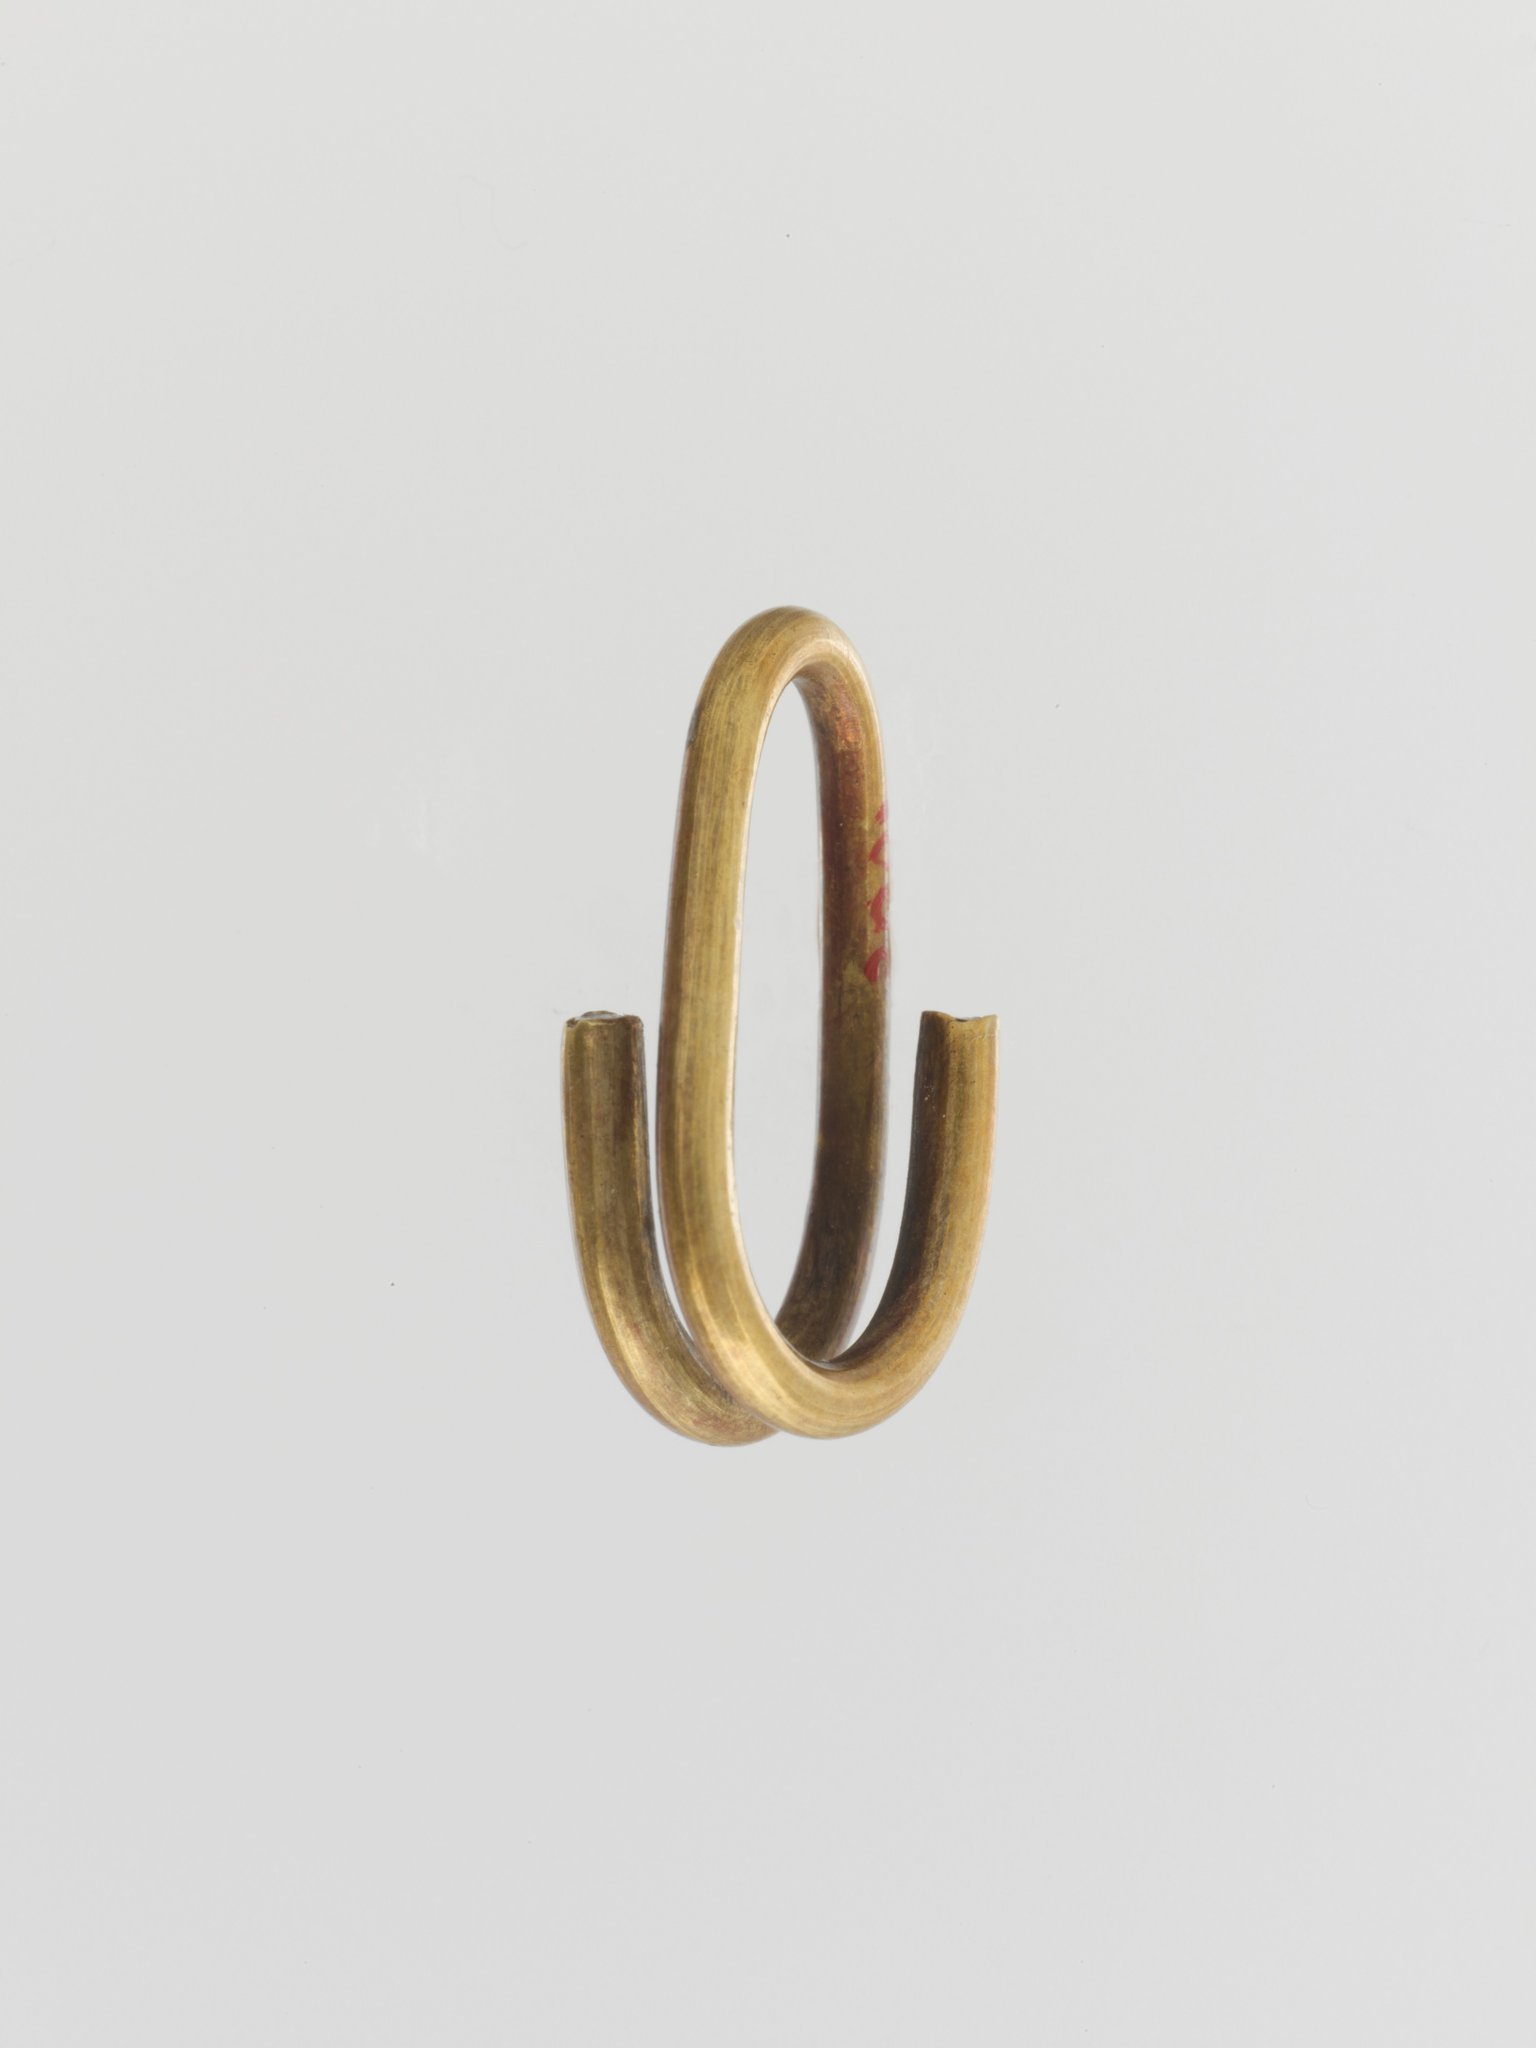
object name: earring or spiral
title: Gold spiral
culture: cypriot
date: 1600-1100 BCE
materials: gold